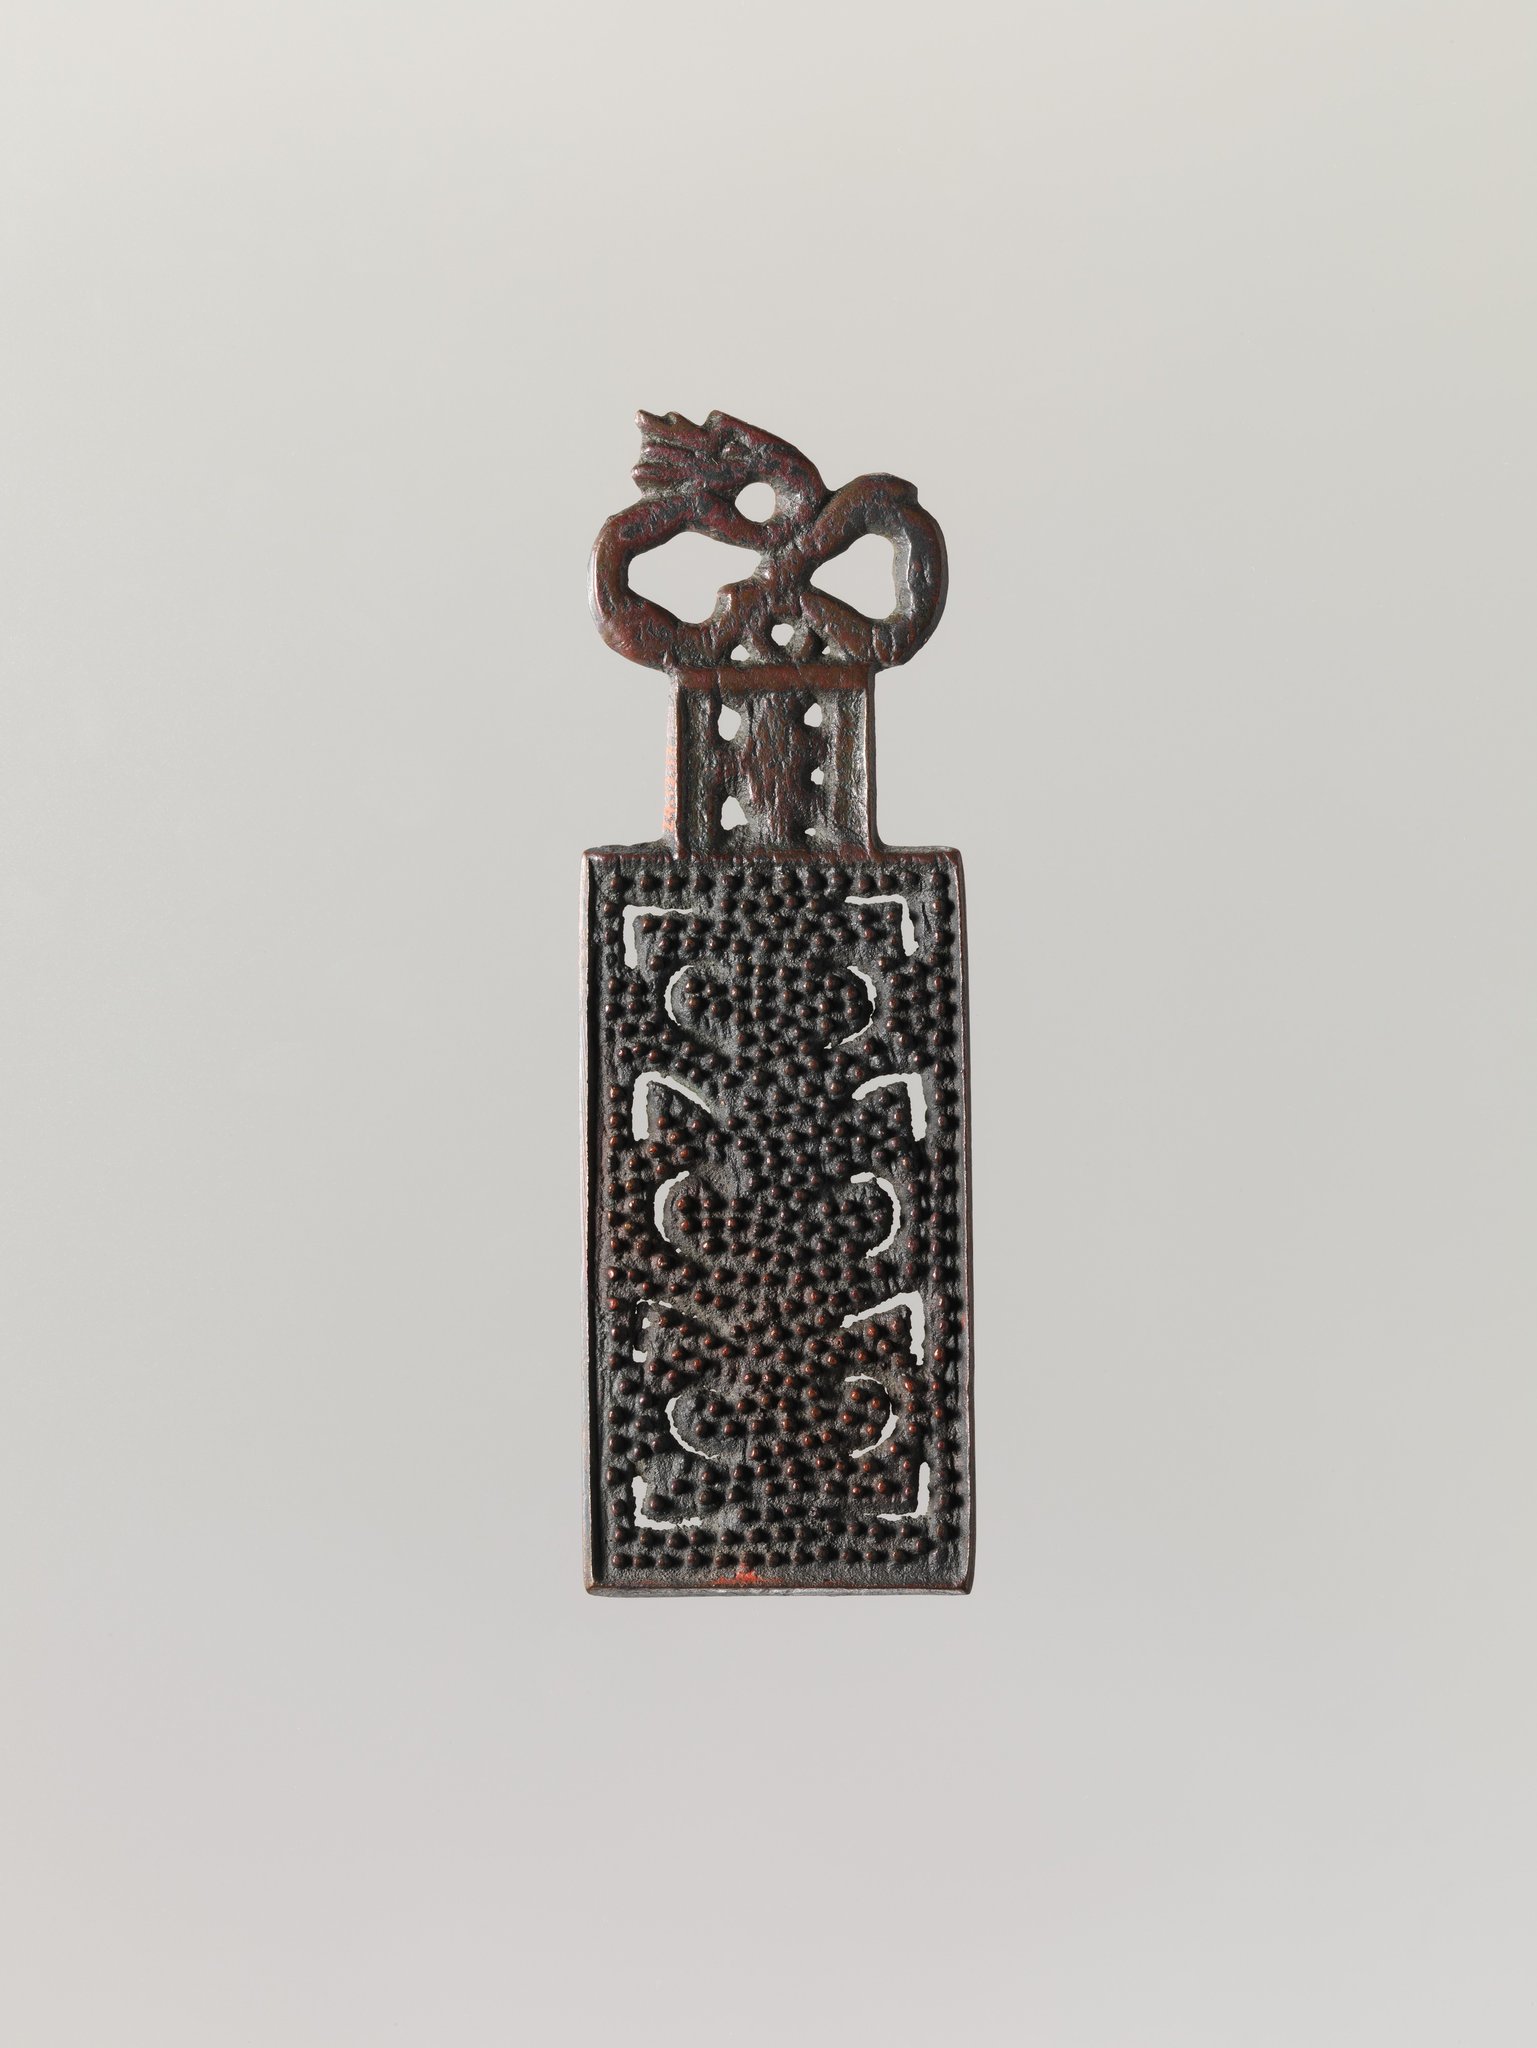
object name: coin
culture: chinese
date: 206 BCE-220 CE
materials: bronze